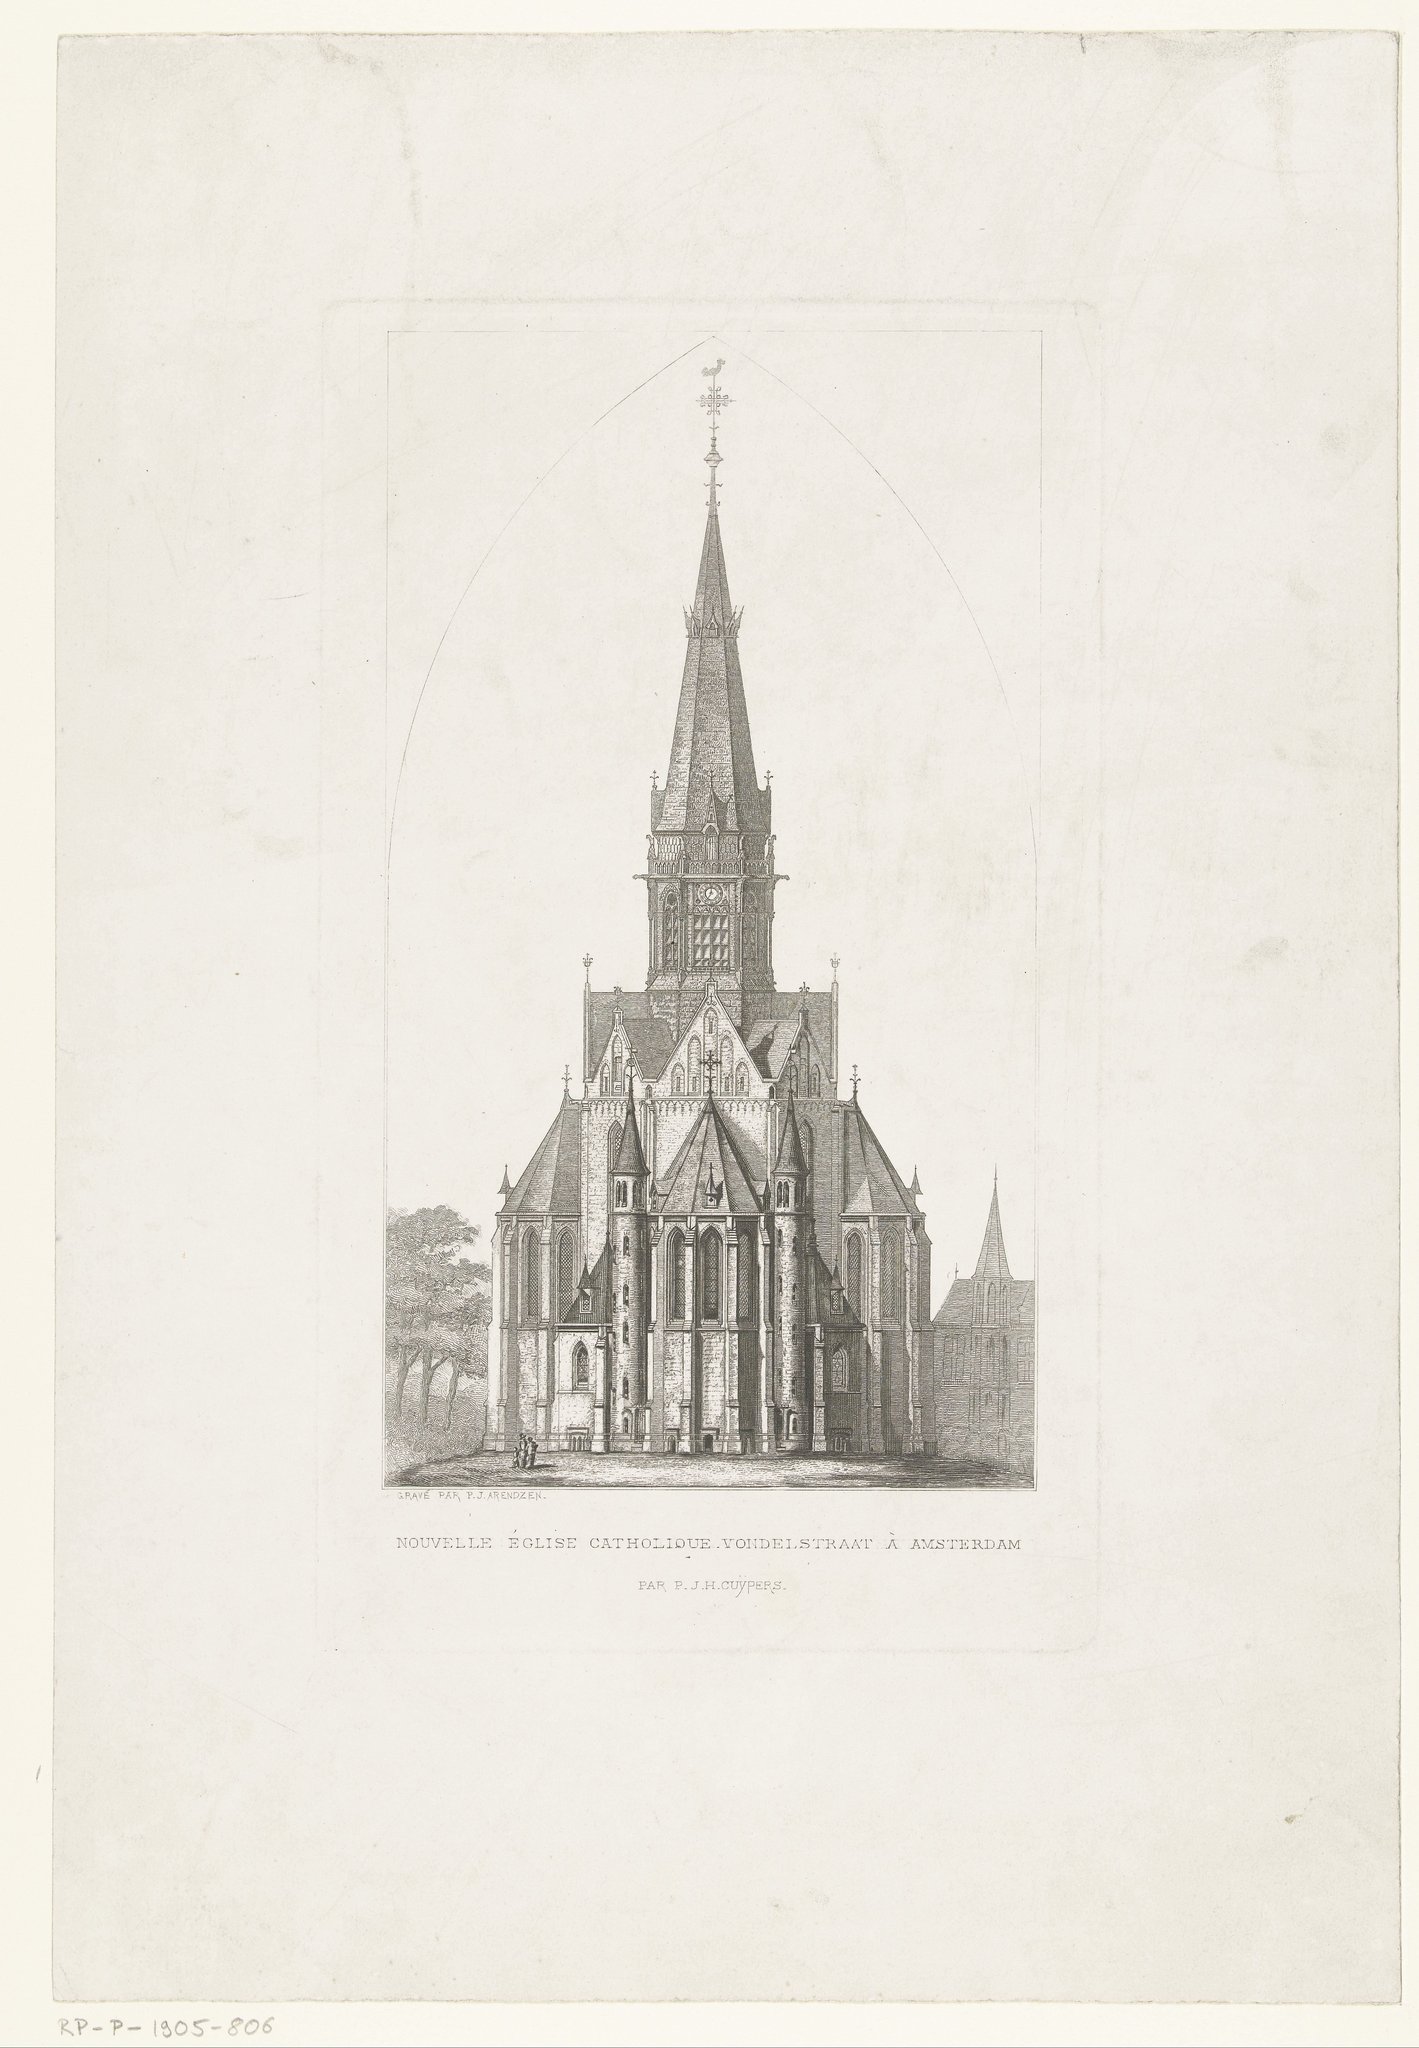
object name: print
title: Gezicht op de oostzijde van de Vondelkerk te Amsterdam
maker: petrus johannes arendzen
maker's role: draughtsman, print maker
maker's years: 1846-1932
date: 1880-1885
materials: paper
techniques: etching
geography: netherlands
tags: vondelkerk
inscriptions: collector's mark: Lugt 2228